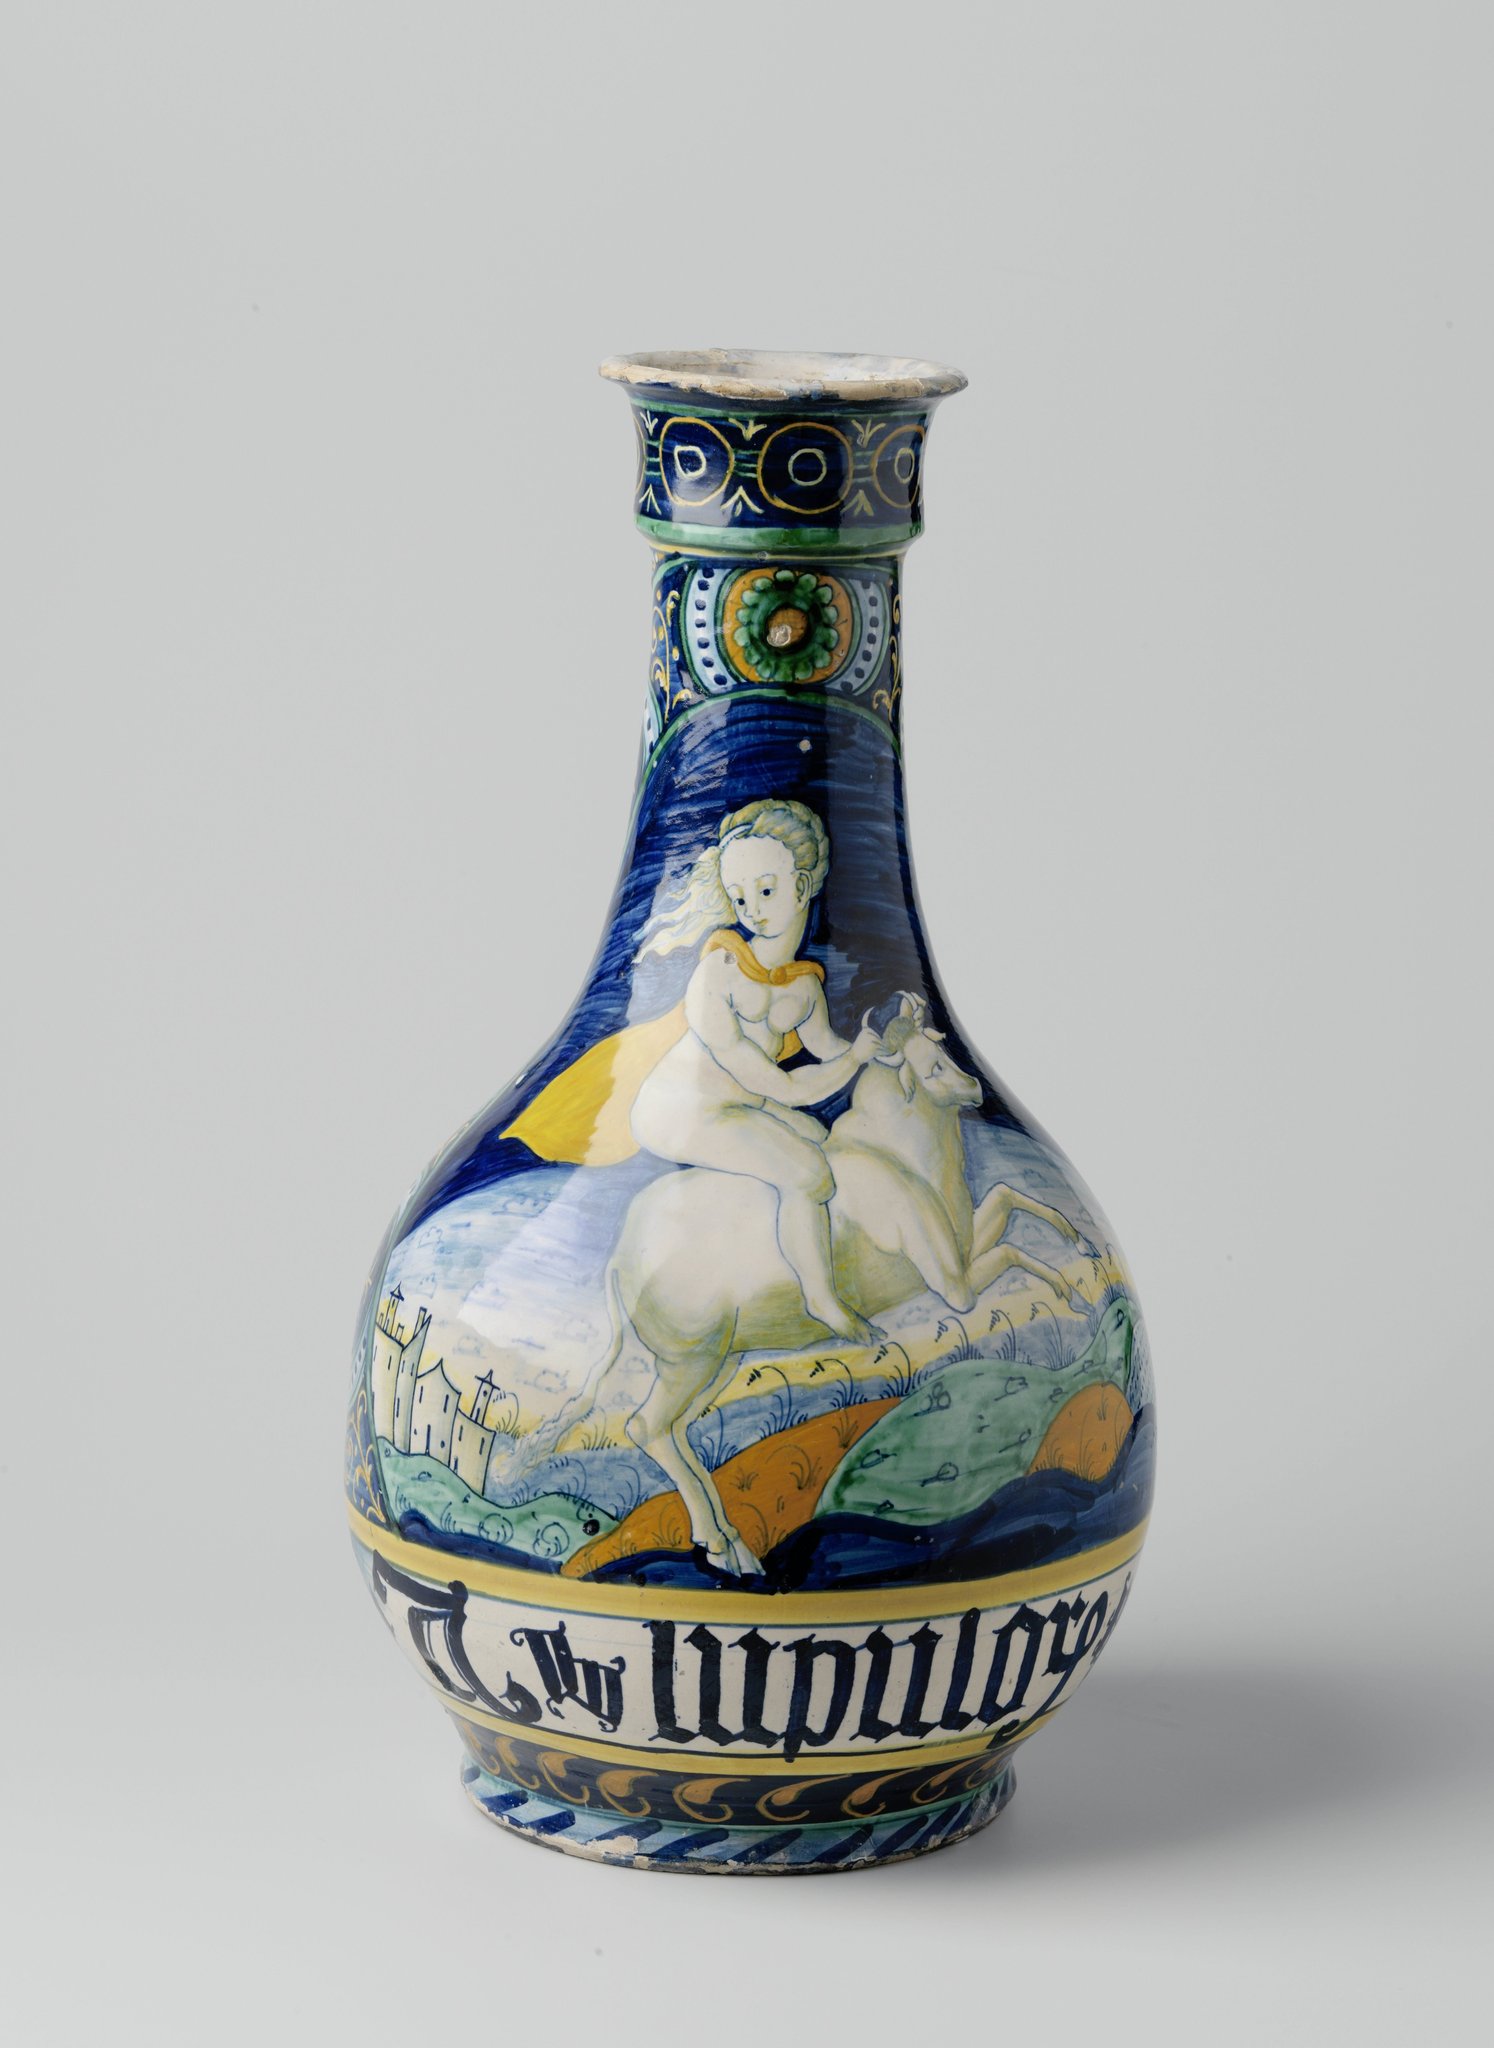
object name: vase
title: Vaas, flesvormig, met opschrift "A LUPOLOS"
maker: Anonymous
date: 1530-1560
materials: earthenware, glaze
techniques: maiolica, painted, polychromy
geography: castelli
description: Drug bottle inscribed A. LUPULOS (hop water) with Europa and the Bull. Maiolica. Castelli, c. 1530 - 1560.